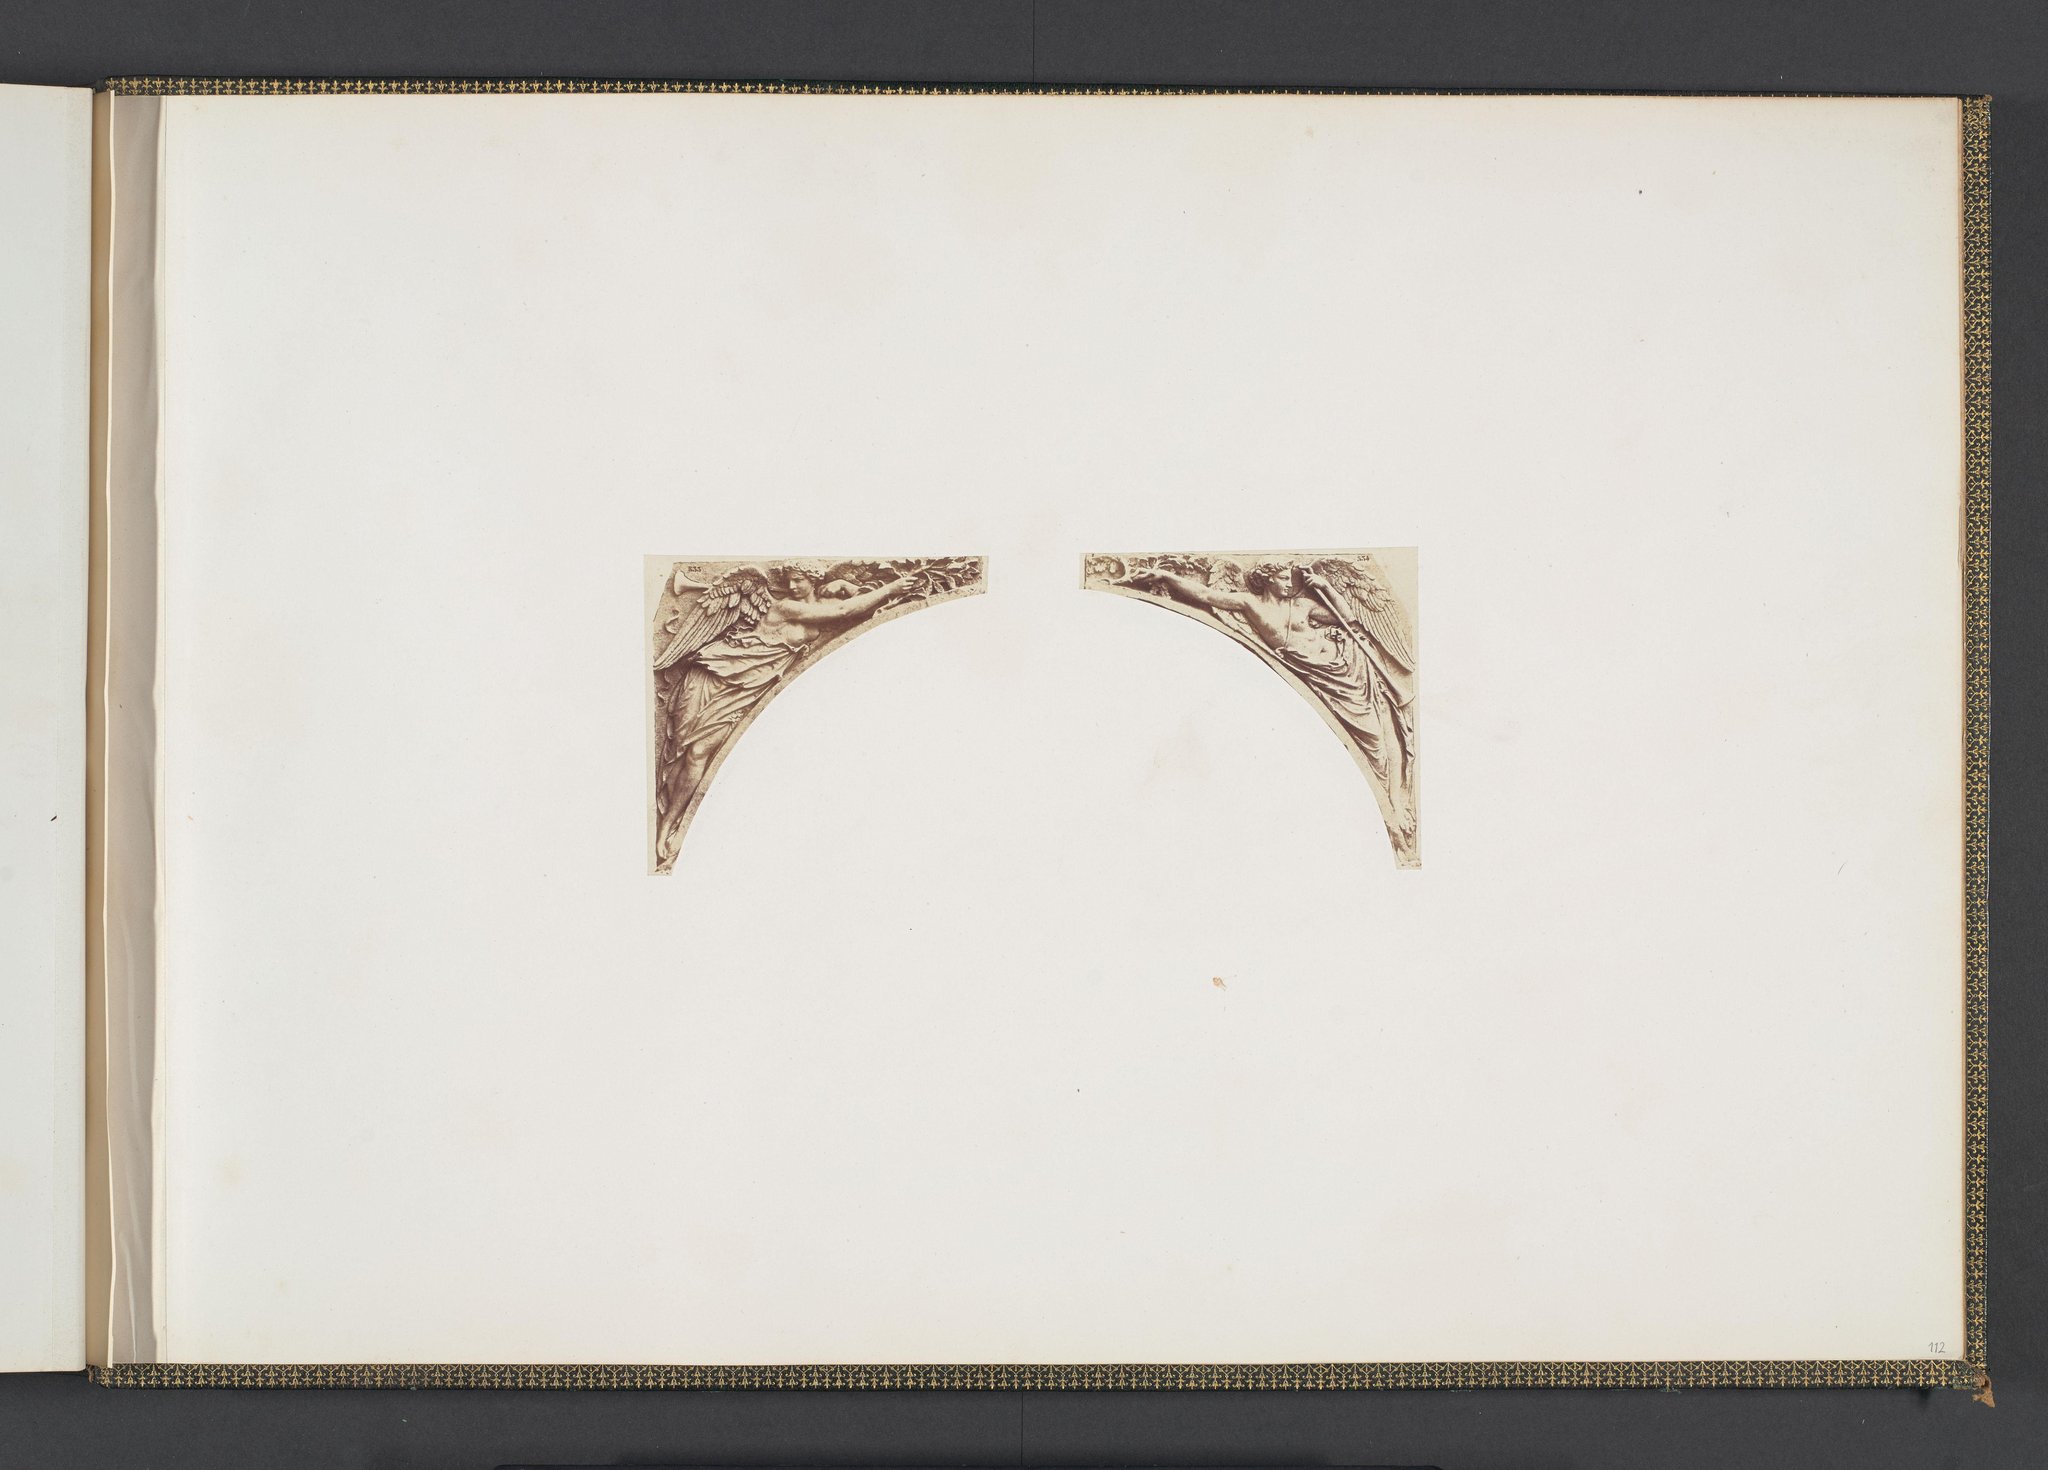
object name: photograph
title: Gipsmodellen voor beeldhouwwerken op het Palais du Louvre: "La Renommée" door Auguste Poitevin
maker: édouard denis baldus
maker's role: fotograaf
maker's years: 1813-1889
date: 1855-1857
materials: paper, photographic support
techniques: salted paper print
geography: paris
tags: piece of sculpture, reproduction of a piece of sculpture, permanent exhibition, museum, paris, tuileries palace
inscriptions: number: ‘533 en 534’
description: Onderdeel van Réunion des Tuileries au Louvre 1852-1857, album 2.